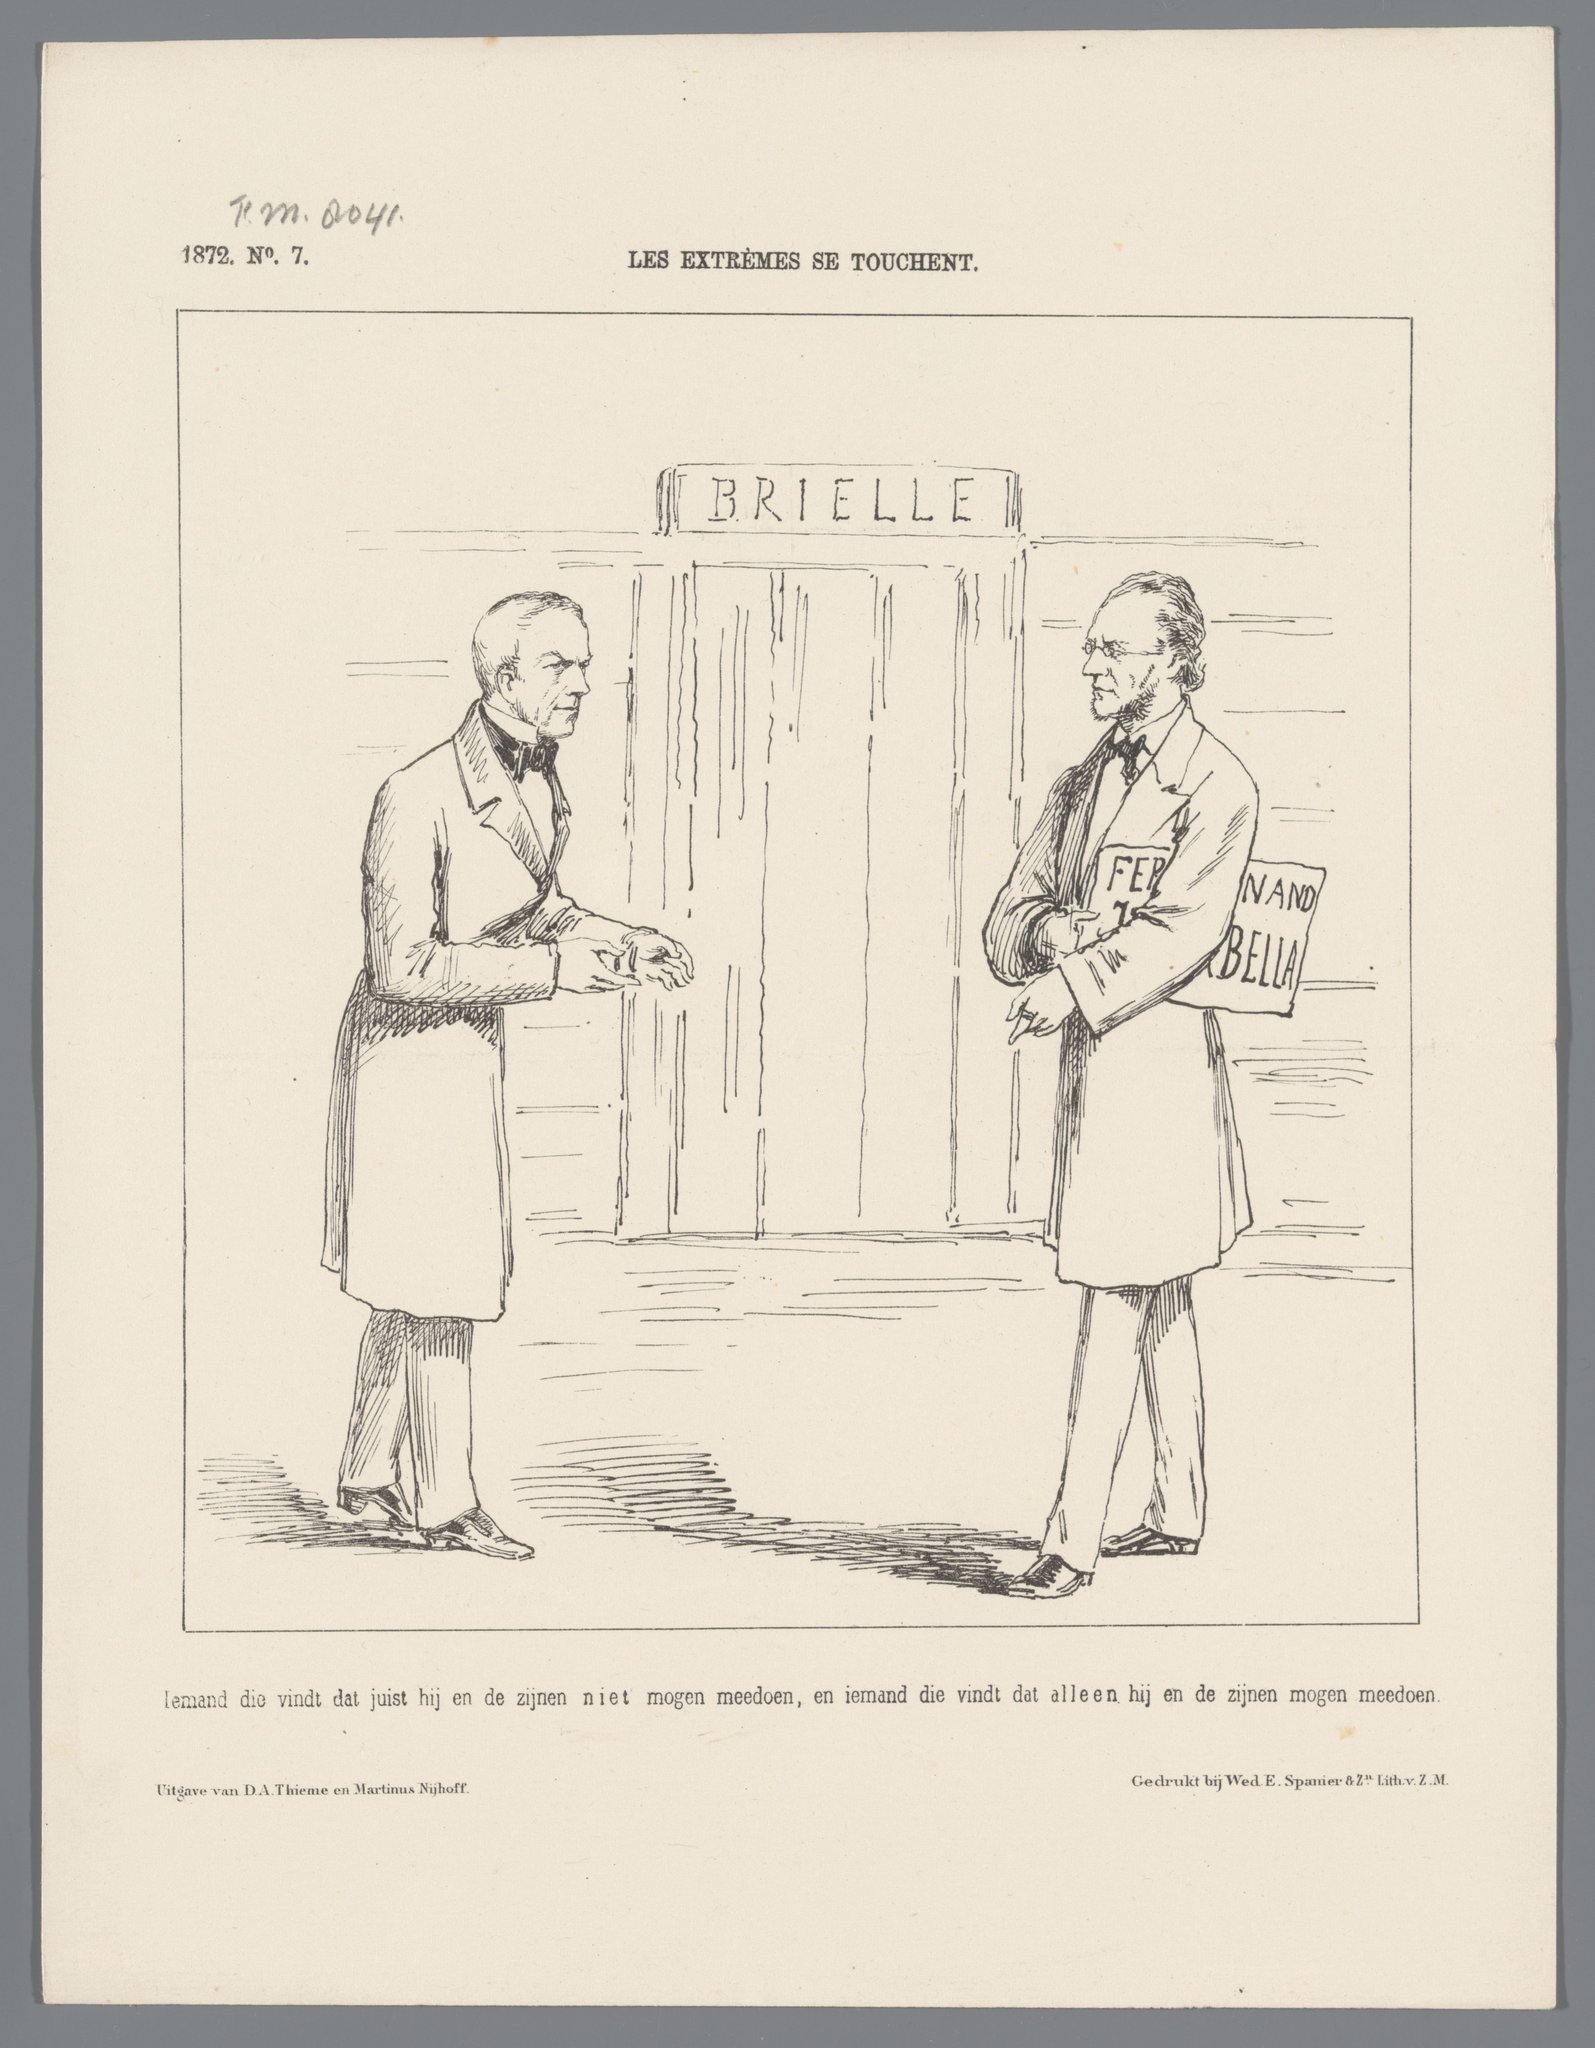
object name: print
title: Les extrèmes se touchent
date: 1872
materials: paper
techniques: lithograph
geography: arnhem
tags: guillaume groen van prinsterer, amsterdam, painter, draughtsman, publisher, josephus albertus alberdingk thijm, brielle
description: Spotprent met Alberdingk Thijm en Groen van Prinsterer nav de twisten over de aanstaande viering van 300 jaar inname van Den Briel. Plaat verschenen bij het weekblad De Nederlandsche Spectator, nr. 7, 1872.